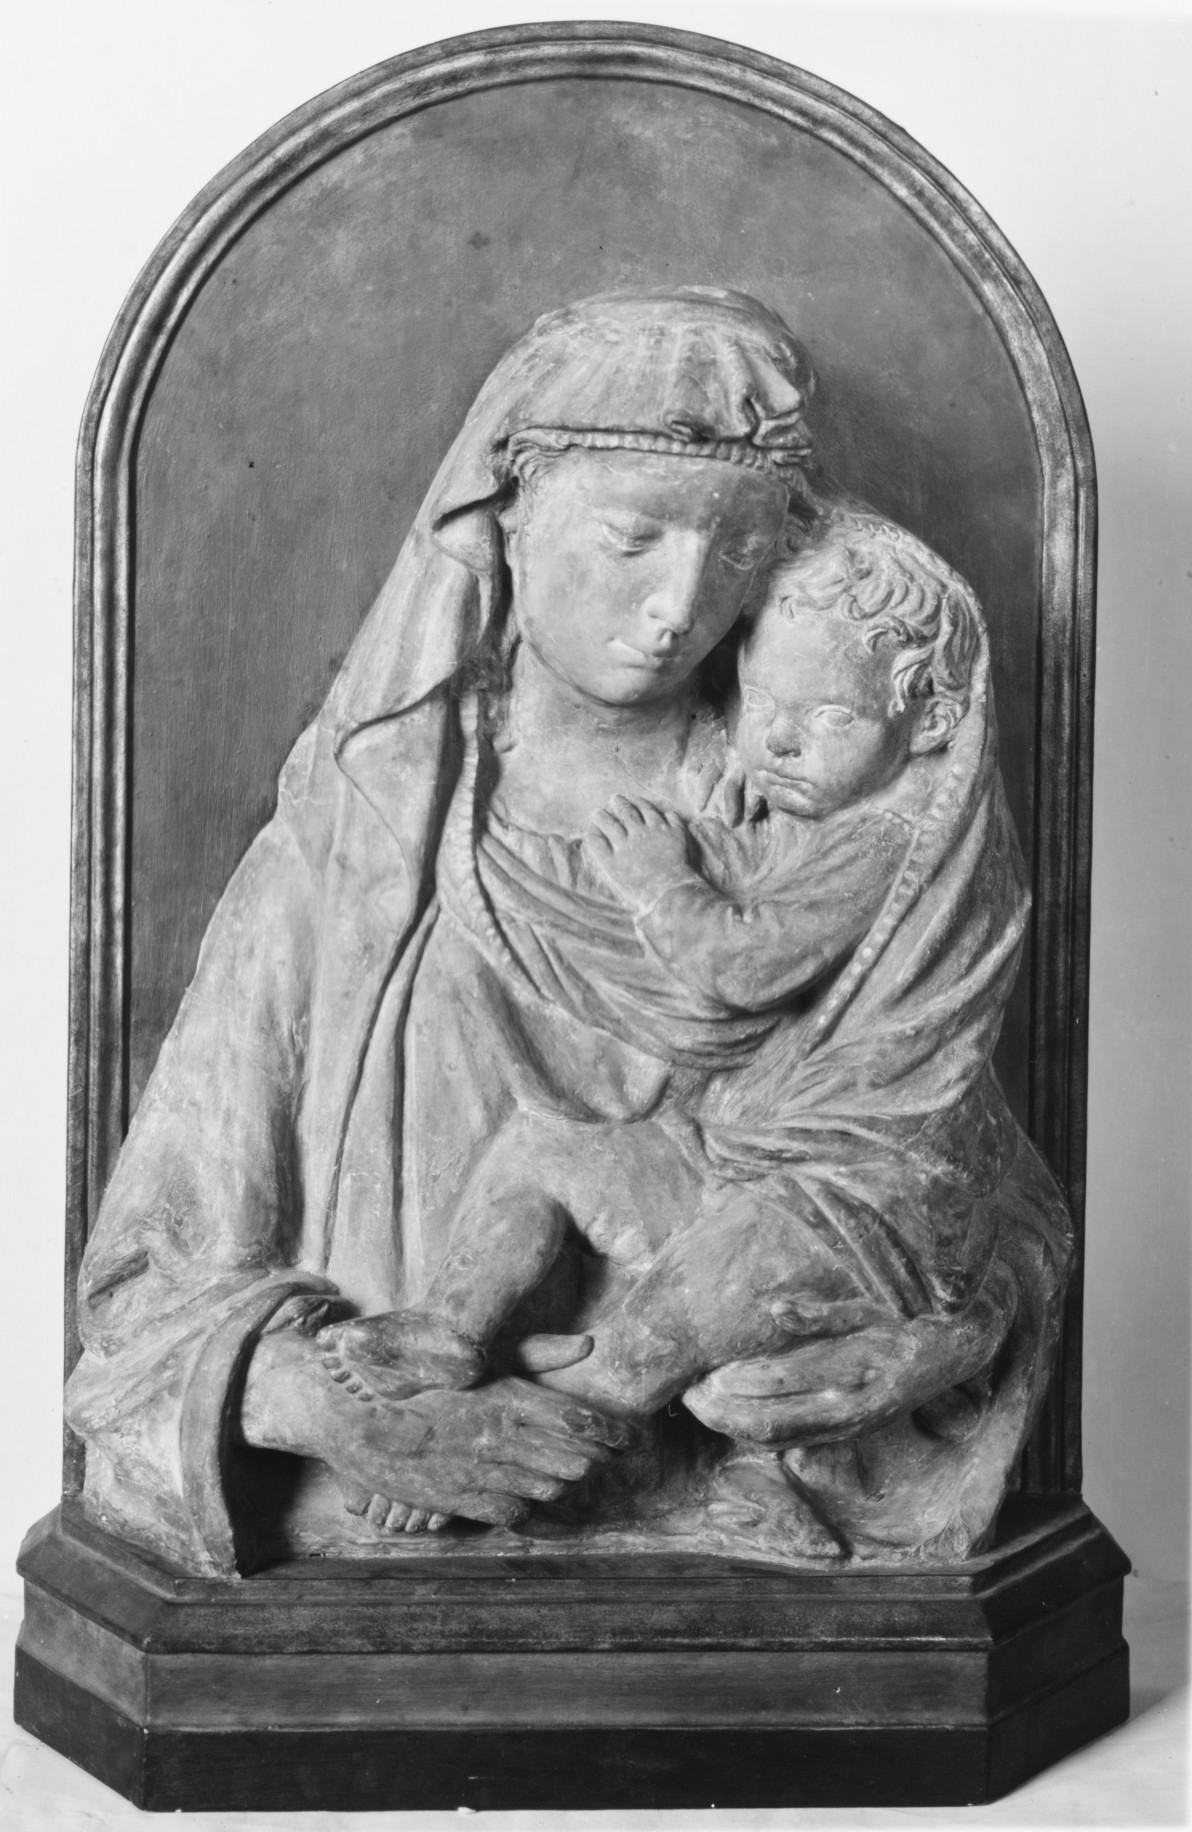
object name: relief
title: Madonna and Child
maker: lorenzo ghiberti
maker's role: artist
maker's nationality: italian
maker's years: 1378-1455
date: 1401-1500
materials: terracotta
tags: madonna and child